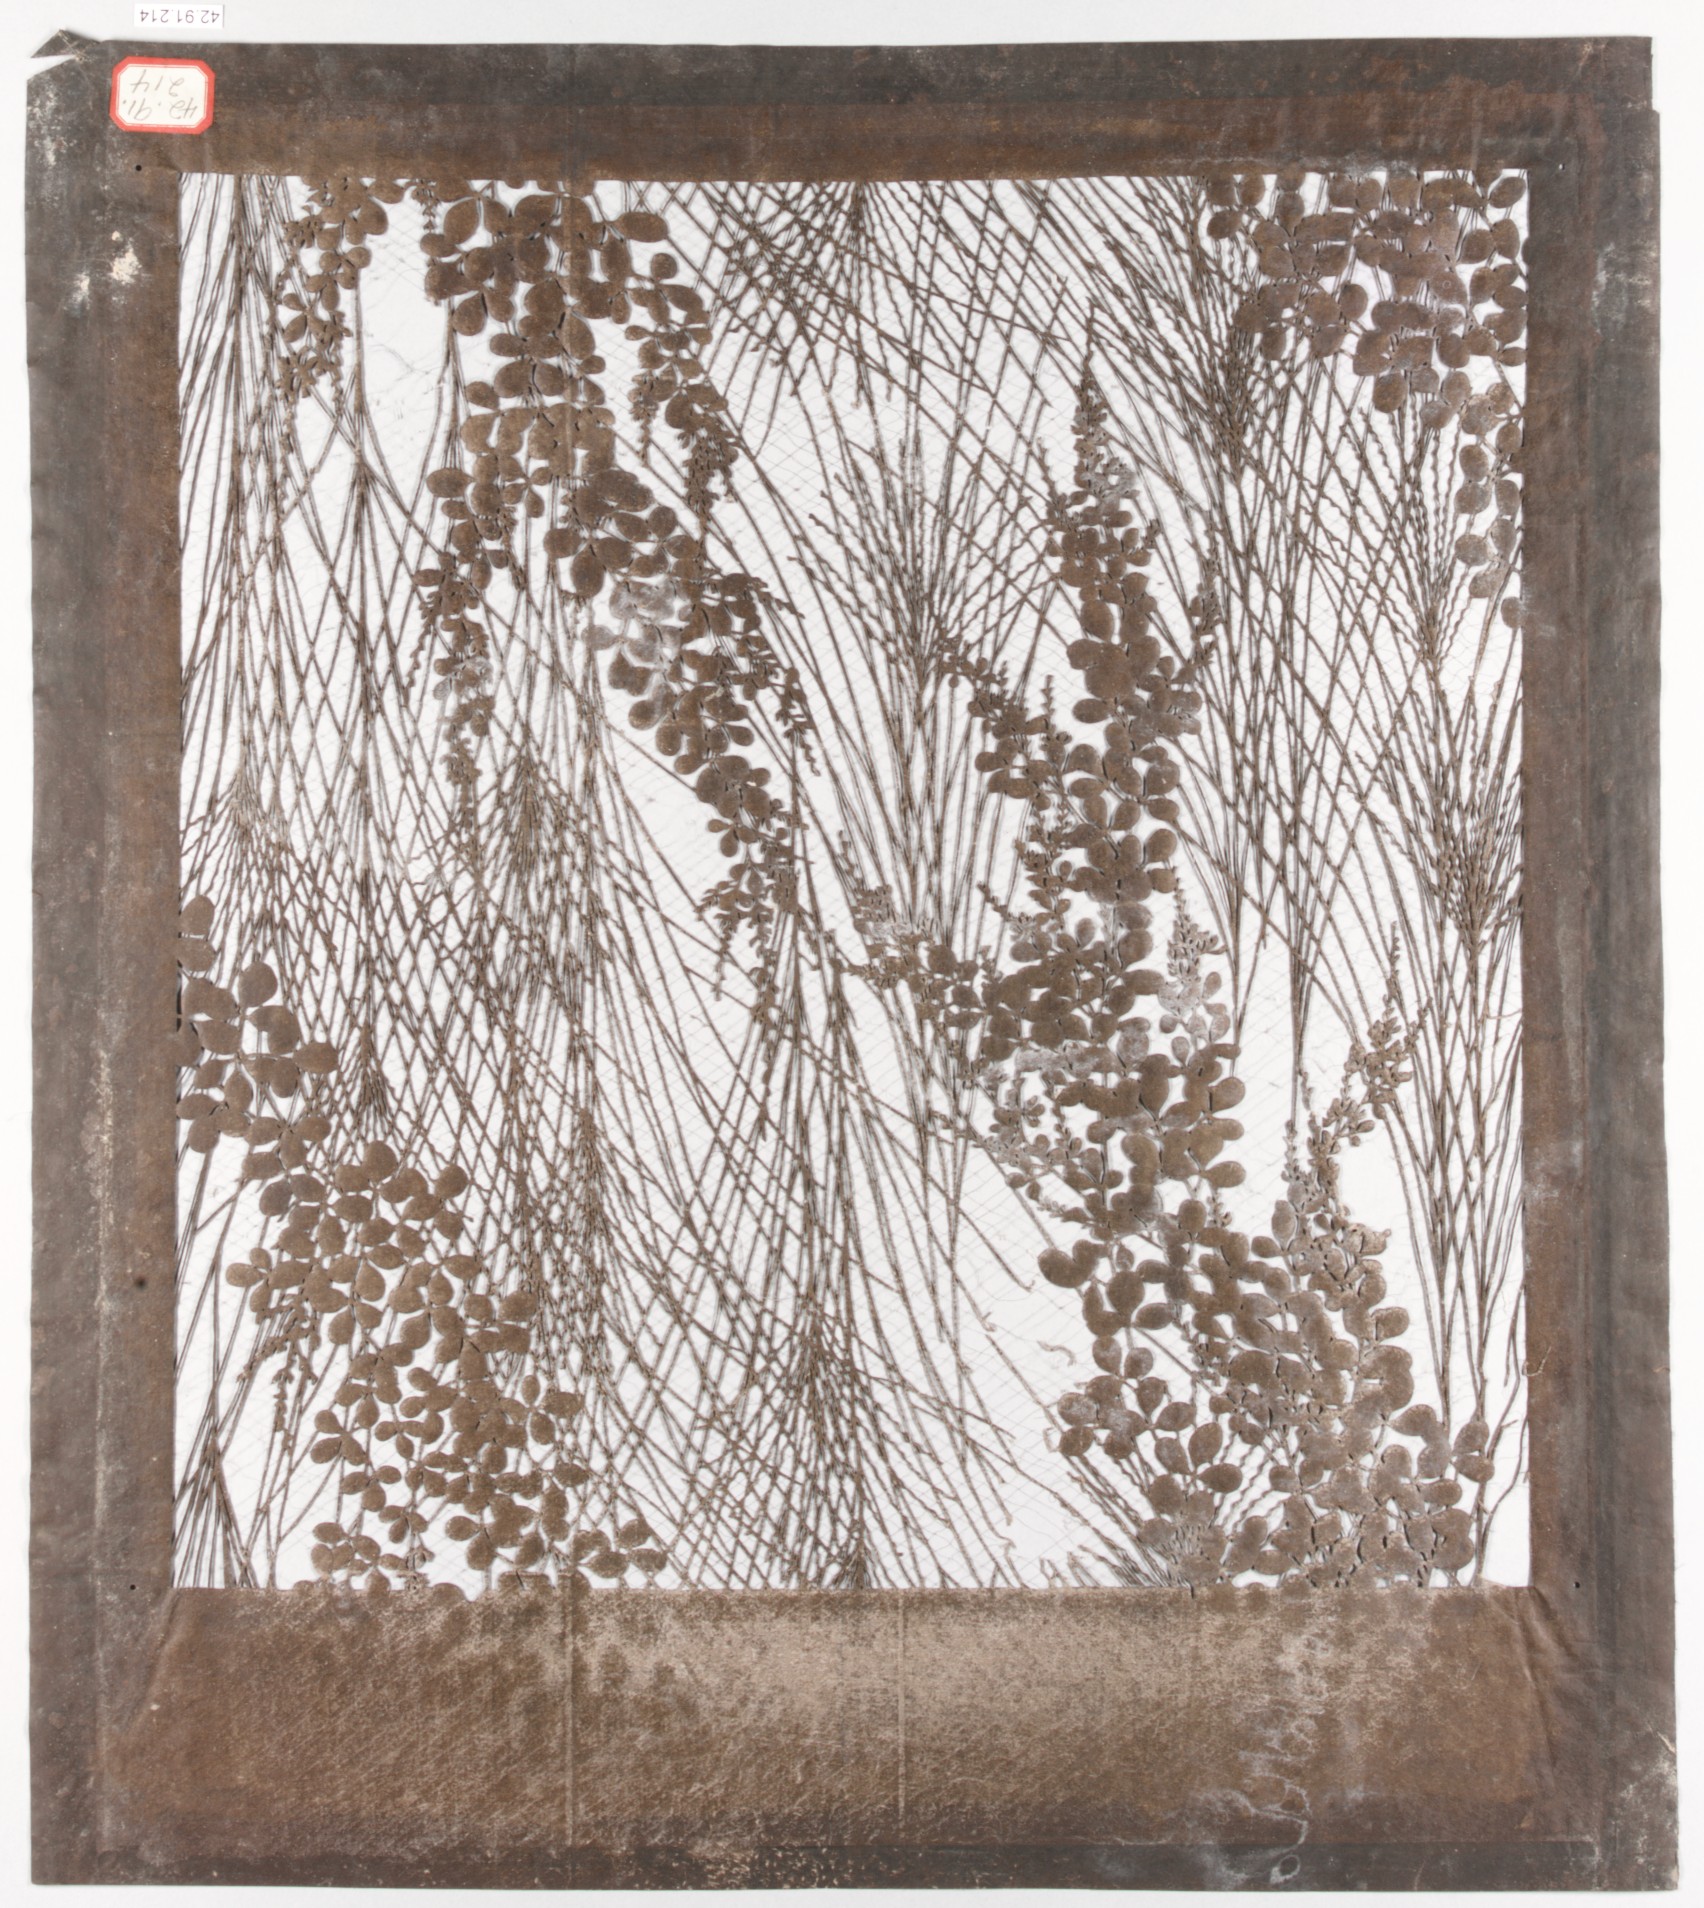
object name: stencil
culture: japanese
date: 1801-1900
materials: paper, silk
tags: plants